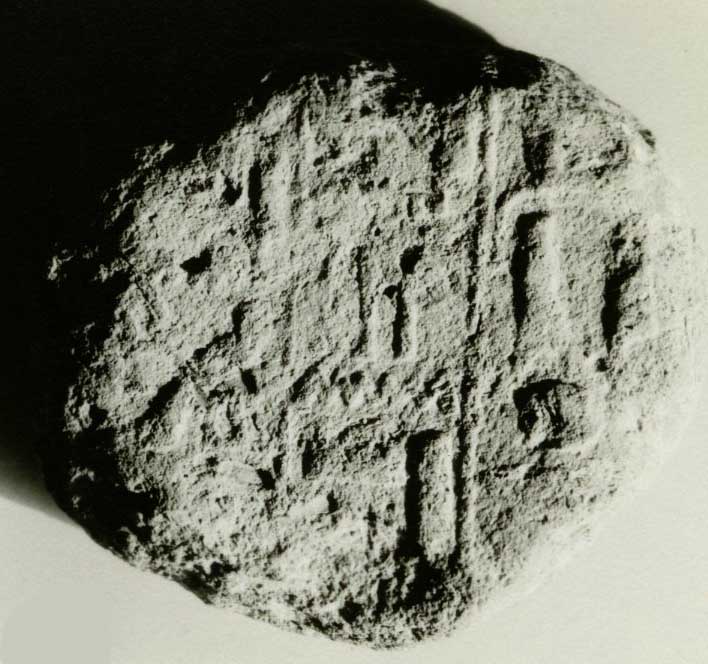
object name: cone, amenemopet, circular impression, high priest, amun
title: Funerary Cone of the High Priest of Amun Amenemopet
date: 1550-1295 BCE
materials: pottery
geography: egypt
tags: hieroglyphs